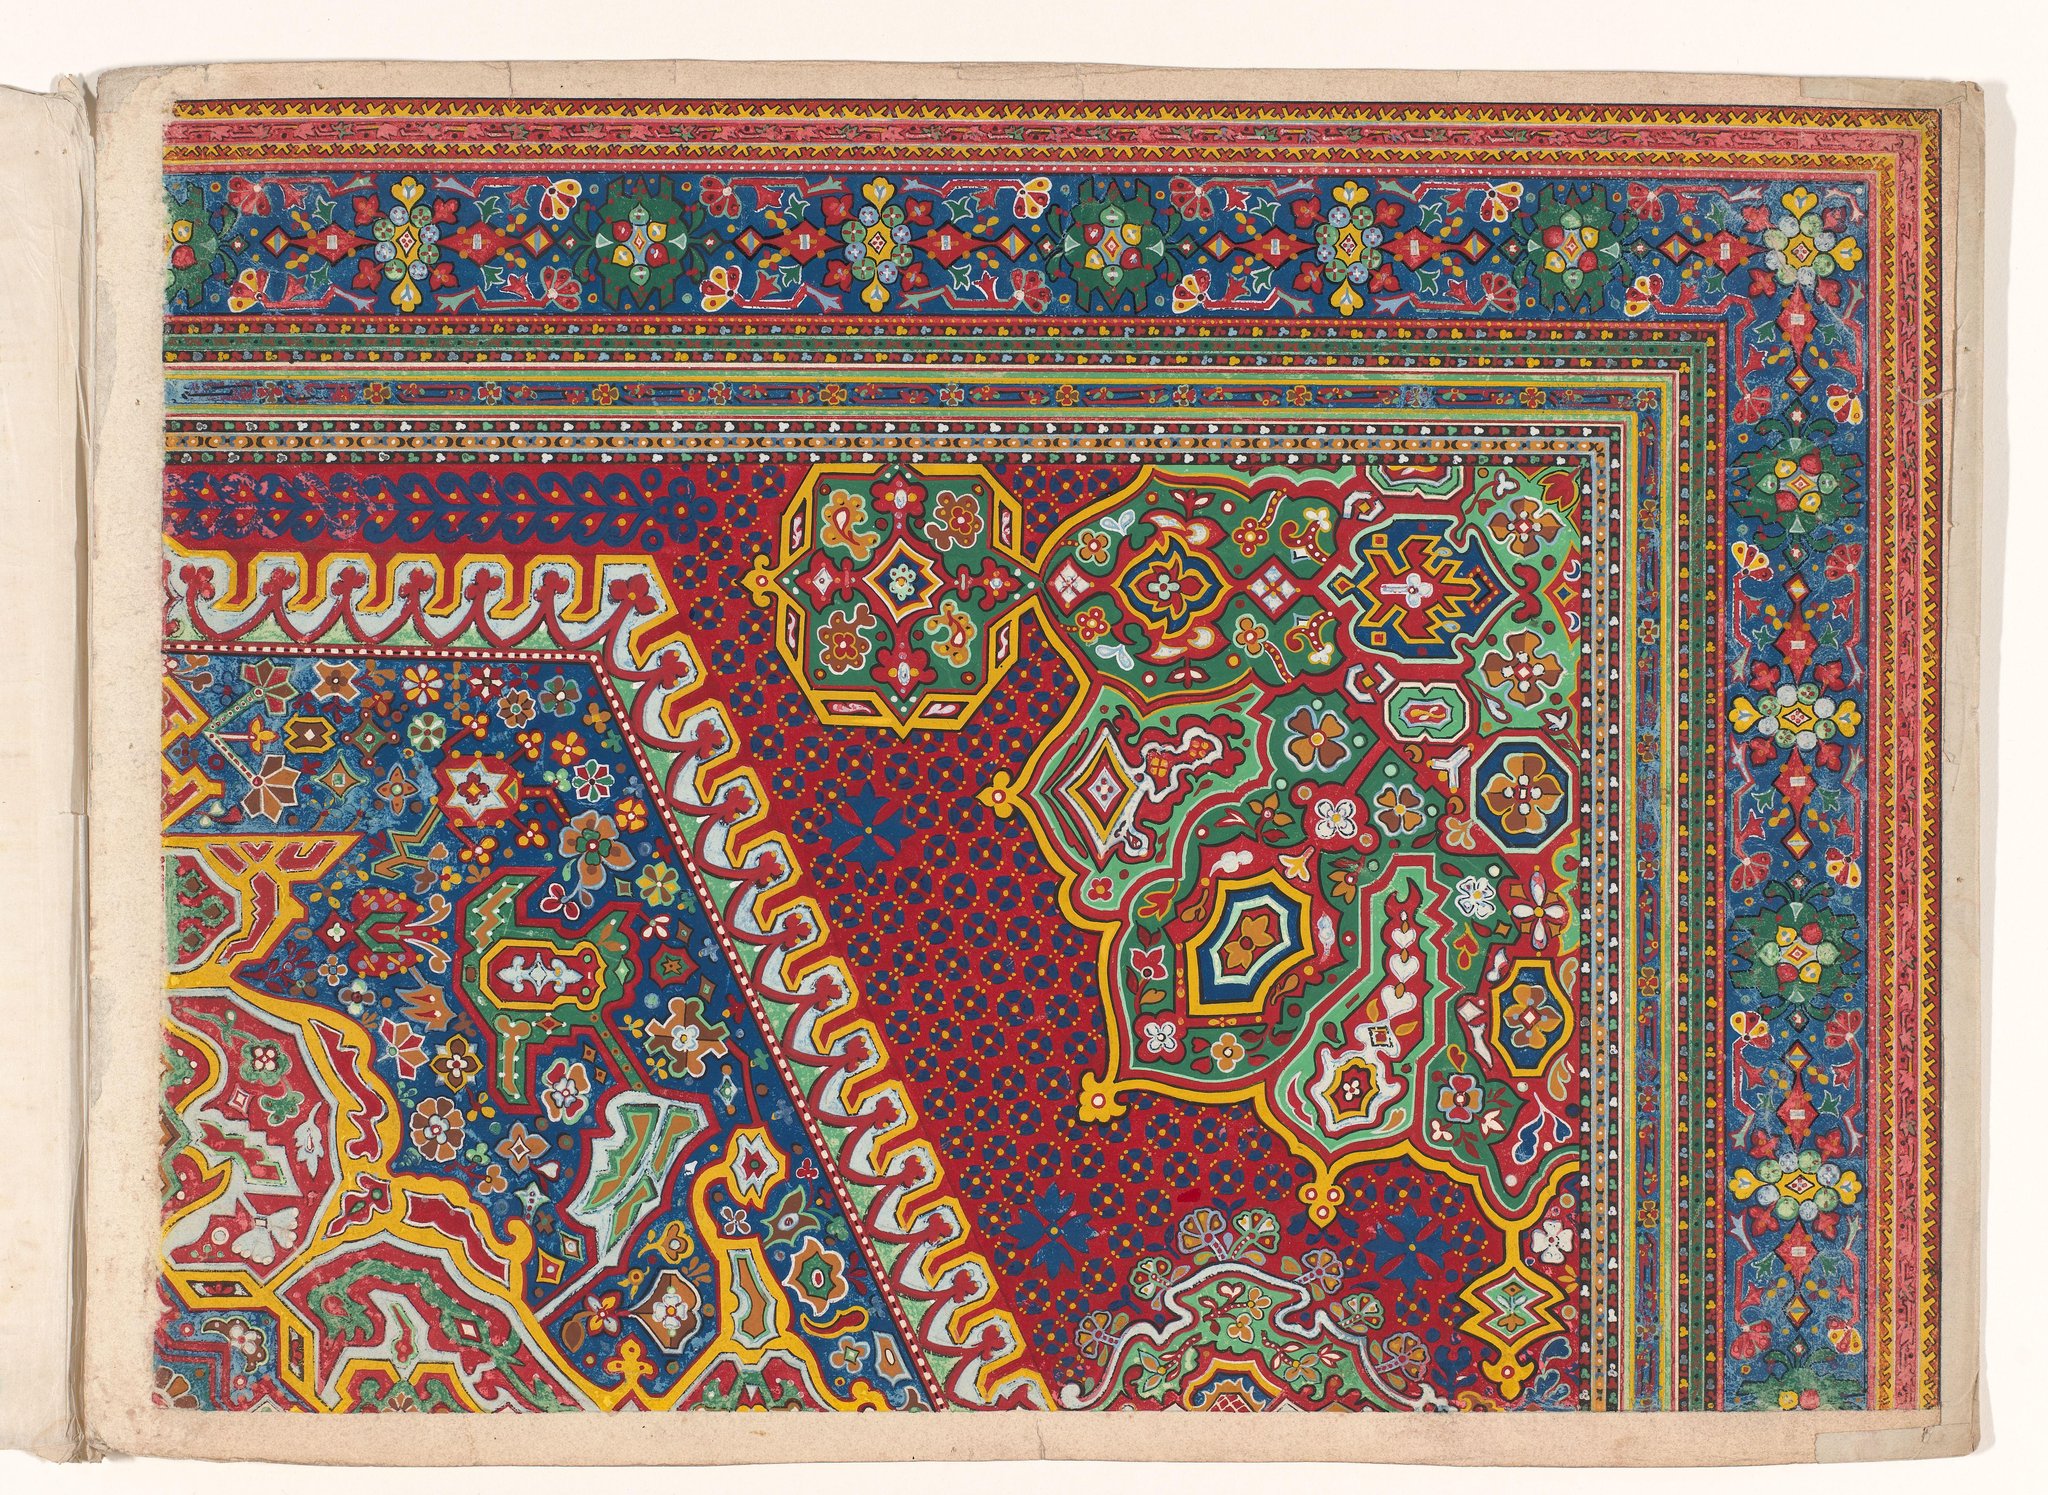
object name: drawing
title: Ontwerp voor een tapijt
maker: Anonymous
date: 1854-1864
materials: gouache, paper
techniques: brush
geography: deventer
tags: ornaments ~ art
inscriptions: retailer's mark: ‘JHS.’, inscription: ‘M’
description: De presentatietekeningen BK-1971-77-1 t/m 86 zijn kopieën van de originele ontwerptekeningen. Ze werden gemaakt voor vertegenwoordigers van bijvoorbeeld magazijnen, die ze aan hun klanten konden tonen. De meeste tekeningen tonen een kwart van het dessin inclusief rand, middenpartij (de zogenaamde grond of fond) en centraal medaillon. Door het gebruik van spiegels kan de illusie van het gehele tapijt worden opgeroepen. Een deel van de tekeningen heeft een alfabetische opeenvolgende letter als kenmerk, de andere groep een cijfer.Waarschijnlijk is de reeks dessins met een letter eerder samengesteld dan de genummerde tekeningen.